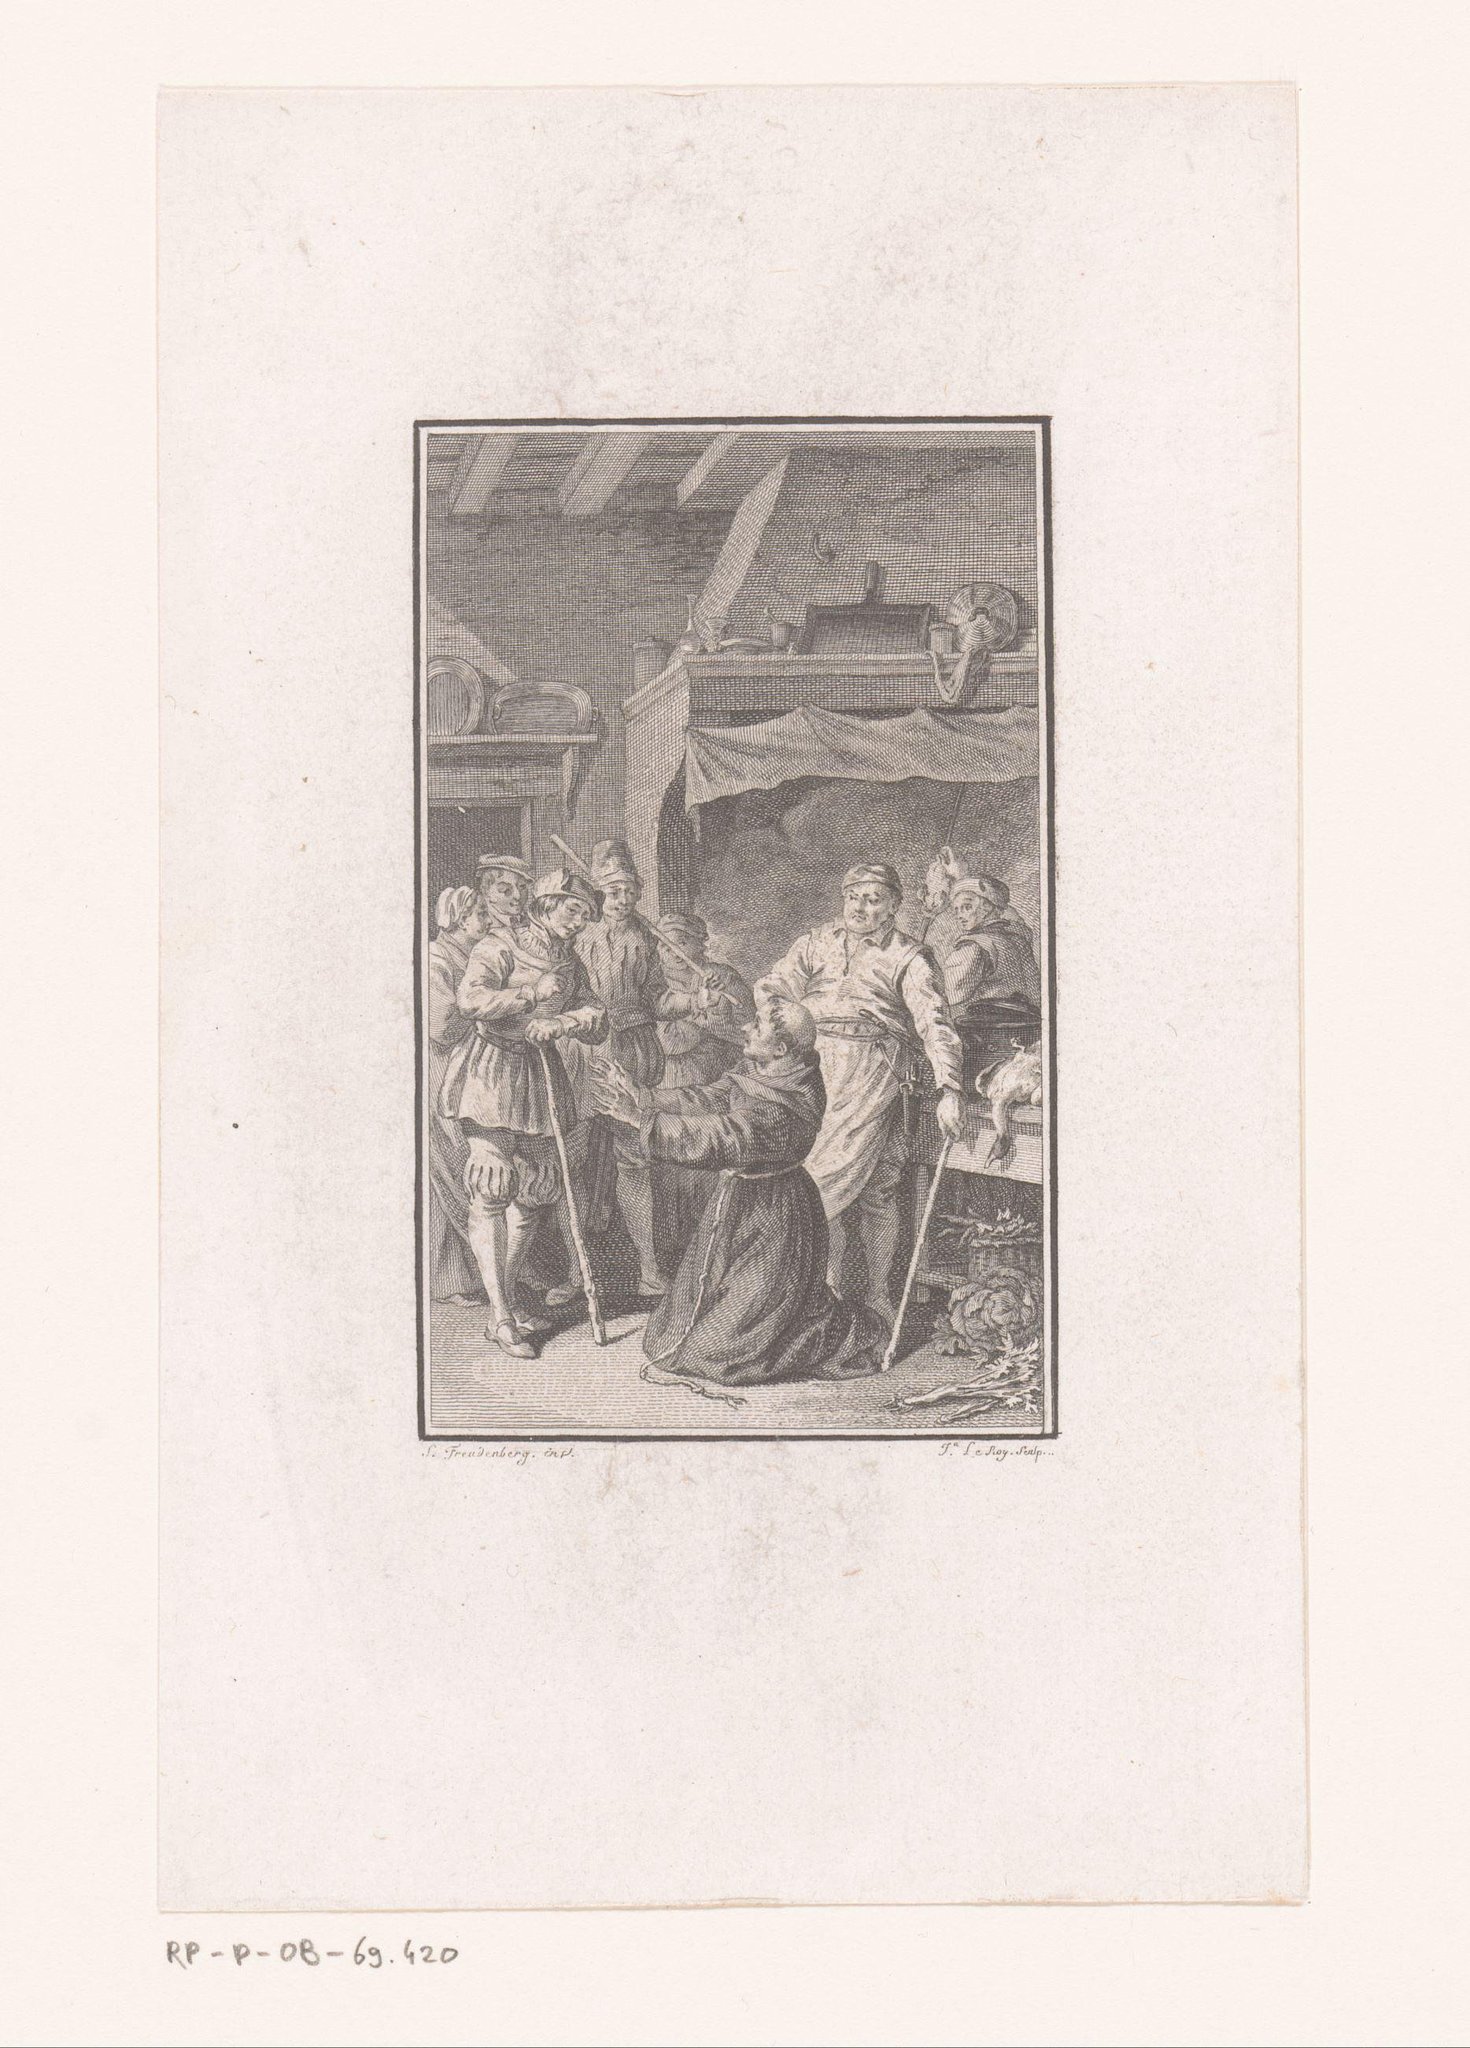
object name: print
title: Interieur met monnik op zijn knieën voor een edelman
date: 1749-1799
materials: paper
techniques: etching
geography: bern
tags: monk(s), friar(s)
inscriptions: collector's mark: Lugt 2228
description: Mogelijk prent uit: Les Nouvelles de Marguerite, reine de Navarre. Bern: la nouvelle Société Typographique, 1780-1781.